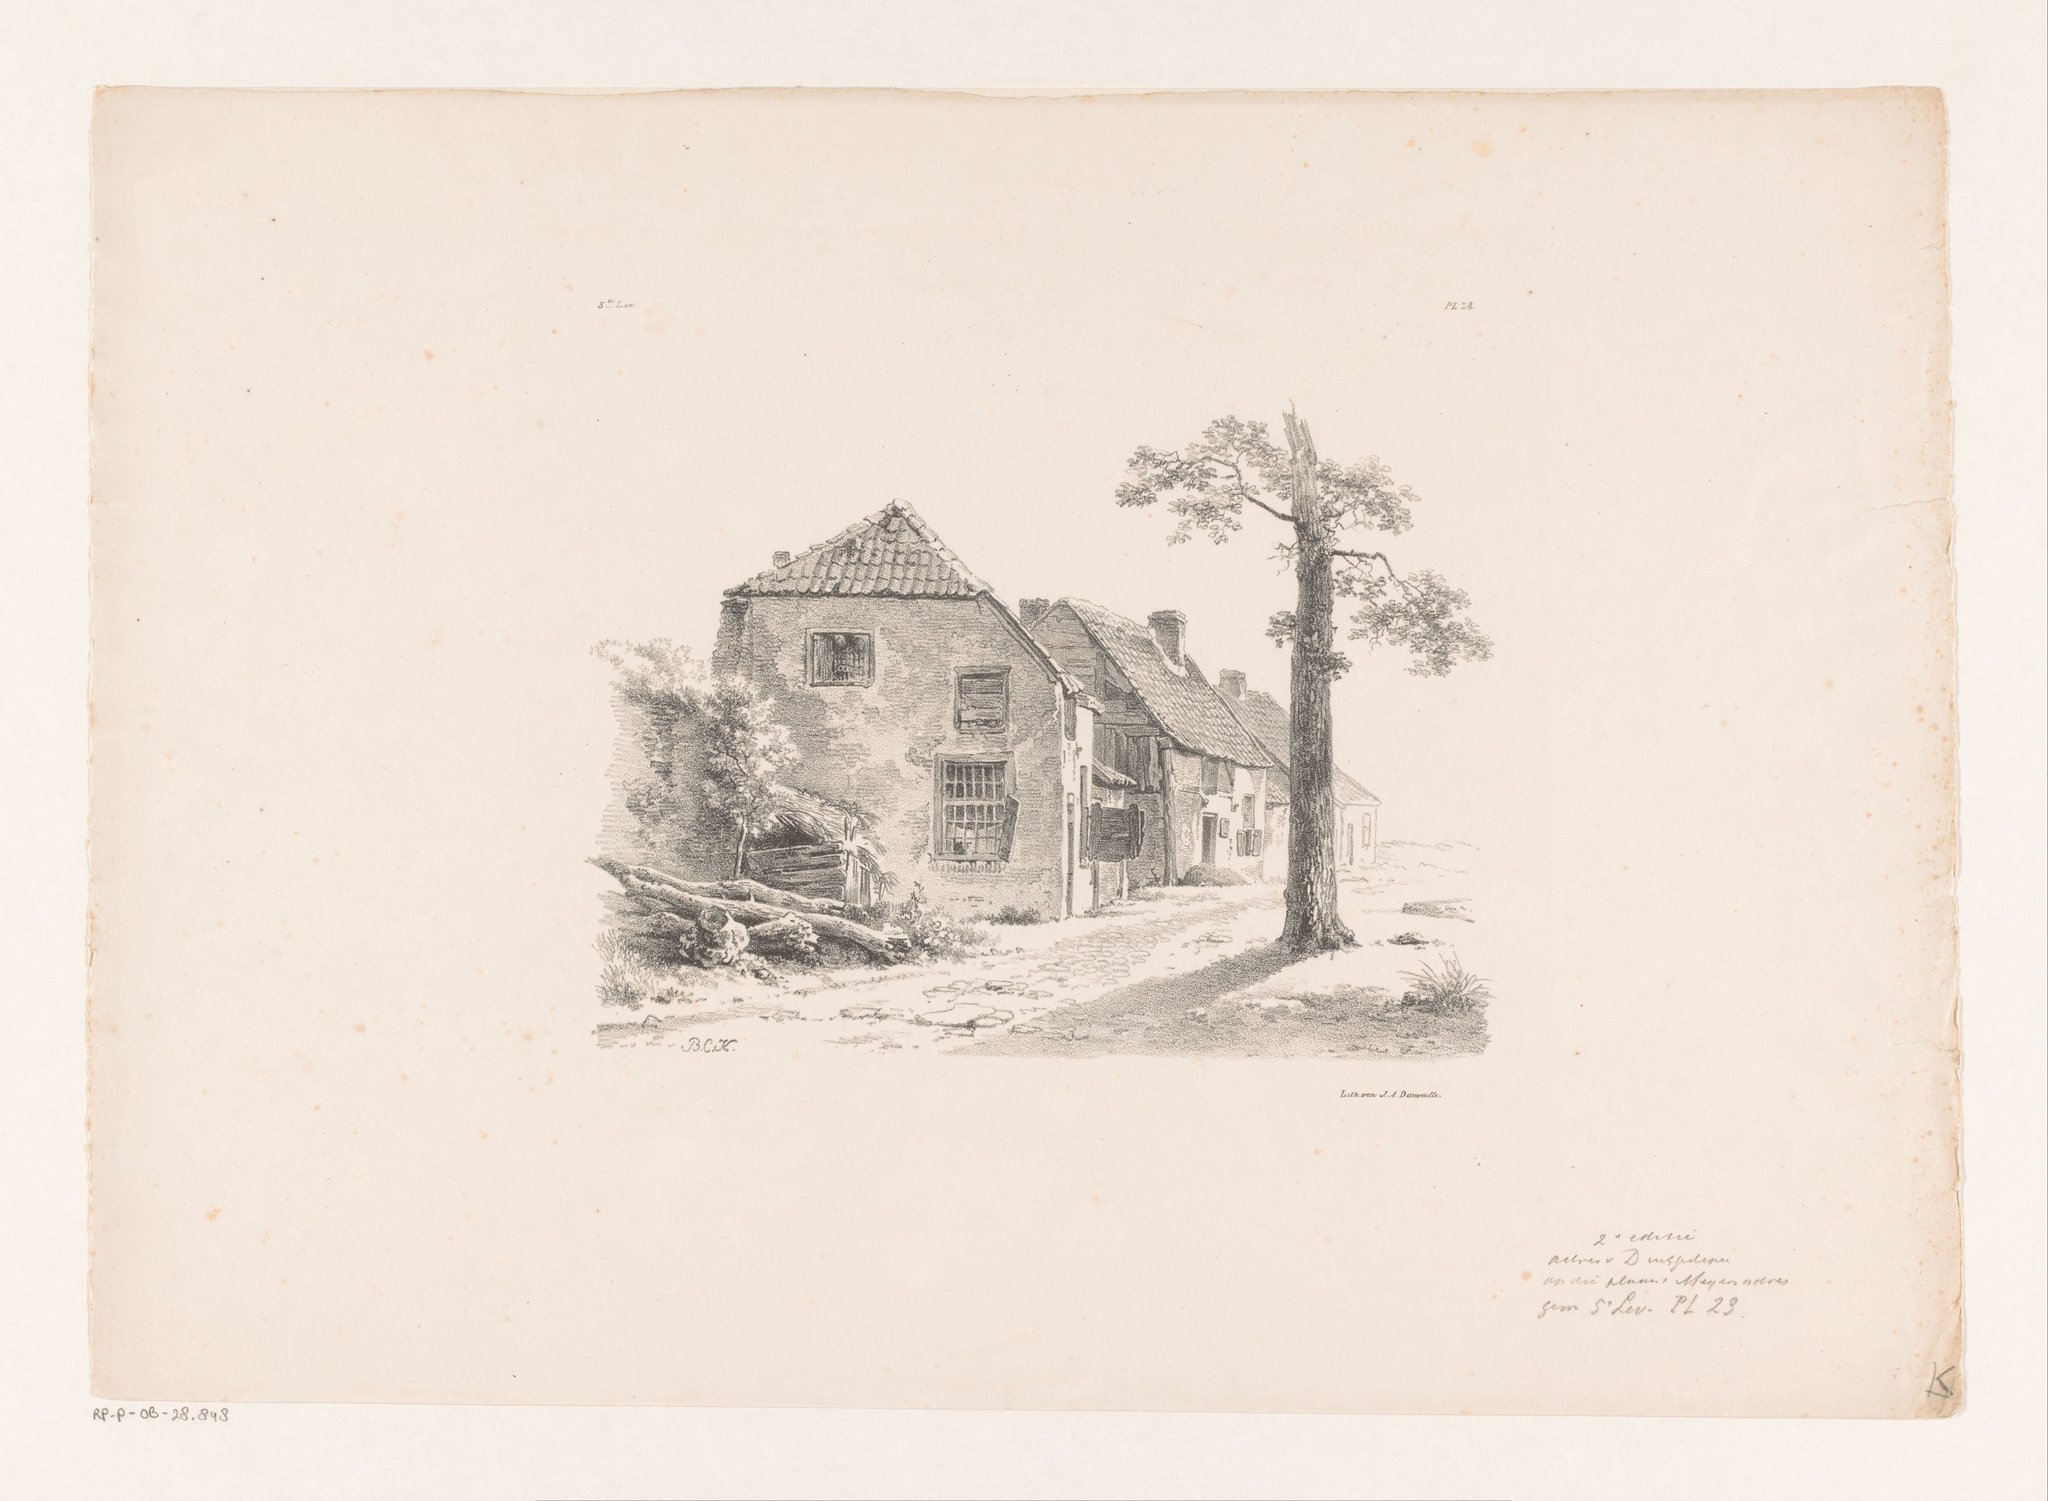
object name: print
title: Landschap studiën vijfde levering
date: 1829-1830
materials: paper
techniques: lithograph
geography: amsterdam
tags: public road, farm (building)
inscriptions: collector's mark: Lugt 2228, inscription: ‘2e editie / adres v D uitgeslepen / op die plaats Meyers adres / gem 5e Lev PL 23’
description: In 1829 en 1830 gaf Koekkoek, samen met Daiwaille, zes cahiers uit met ieder zes prenten getiteld Landschapstudiën. Deze werden gebruikt in het tekenonderwijs. Vijftien jaar later werd deze reeks, in een andere samenstelling nogmaals uitgegeven door Meyer en Comp in Amsterdam. Zie: De Bruyn Kops, 1963.